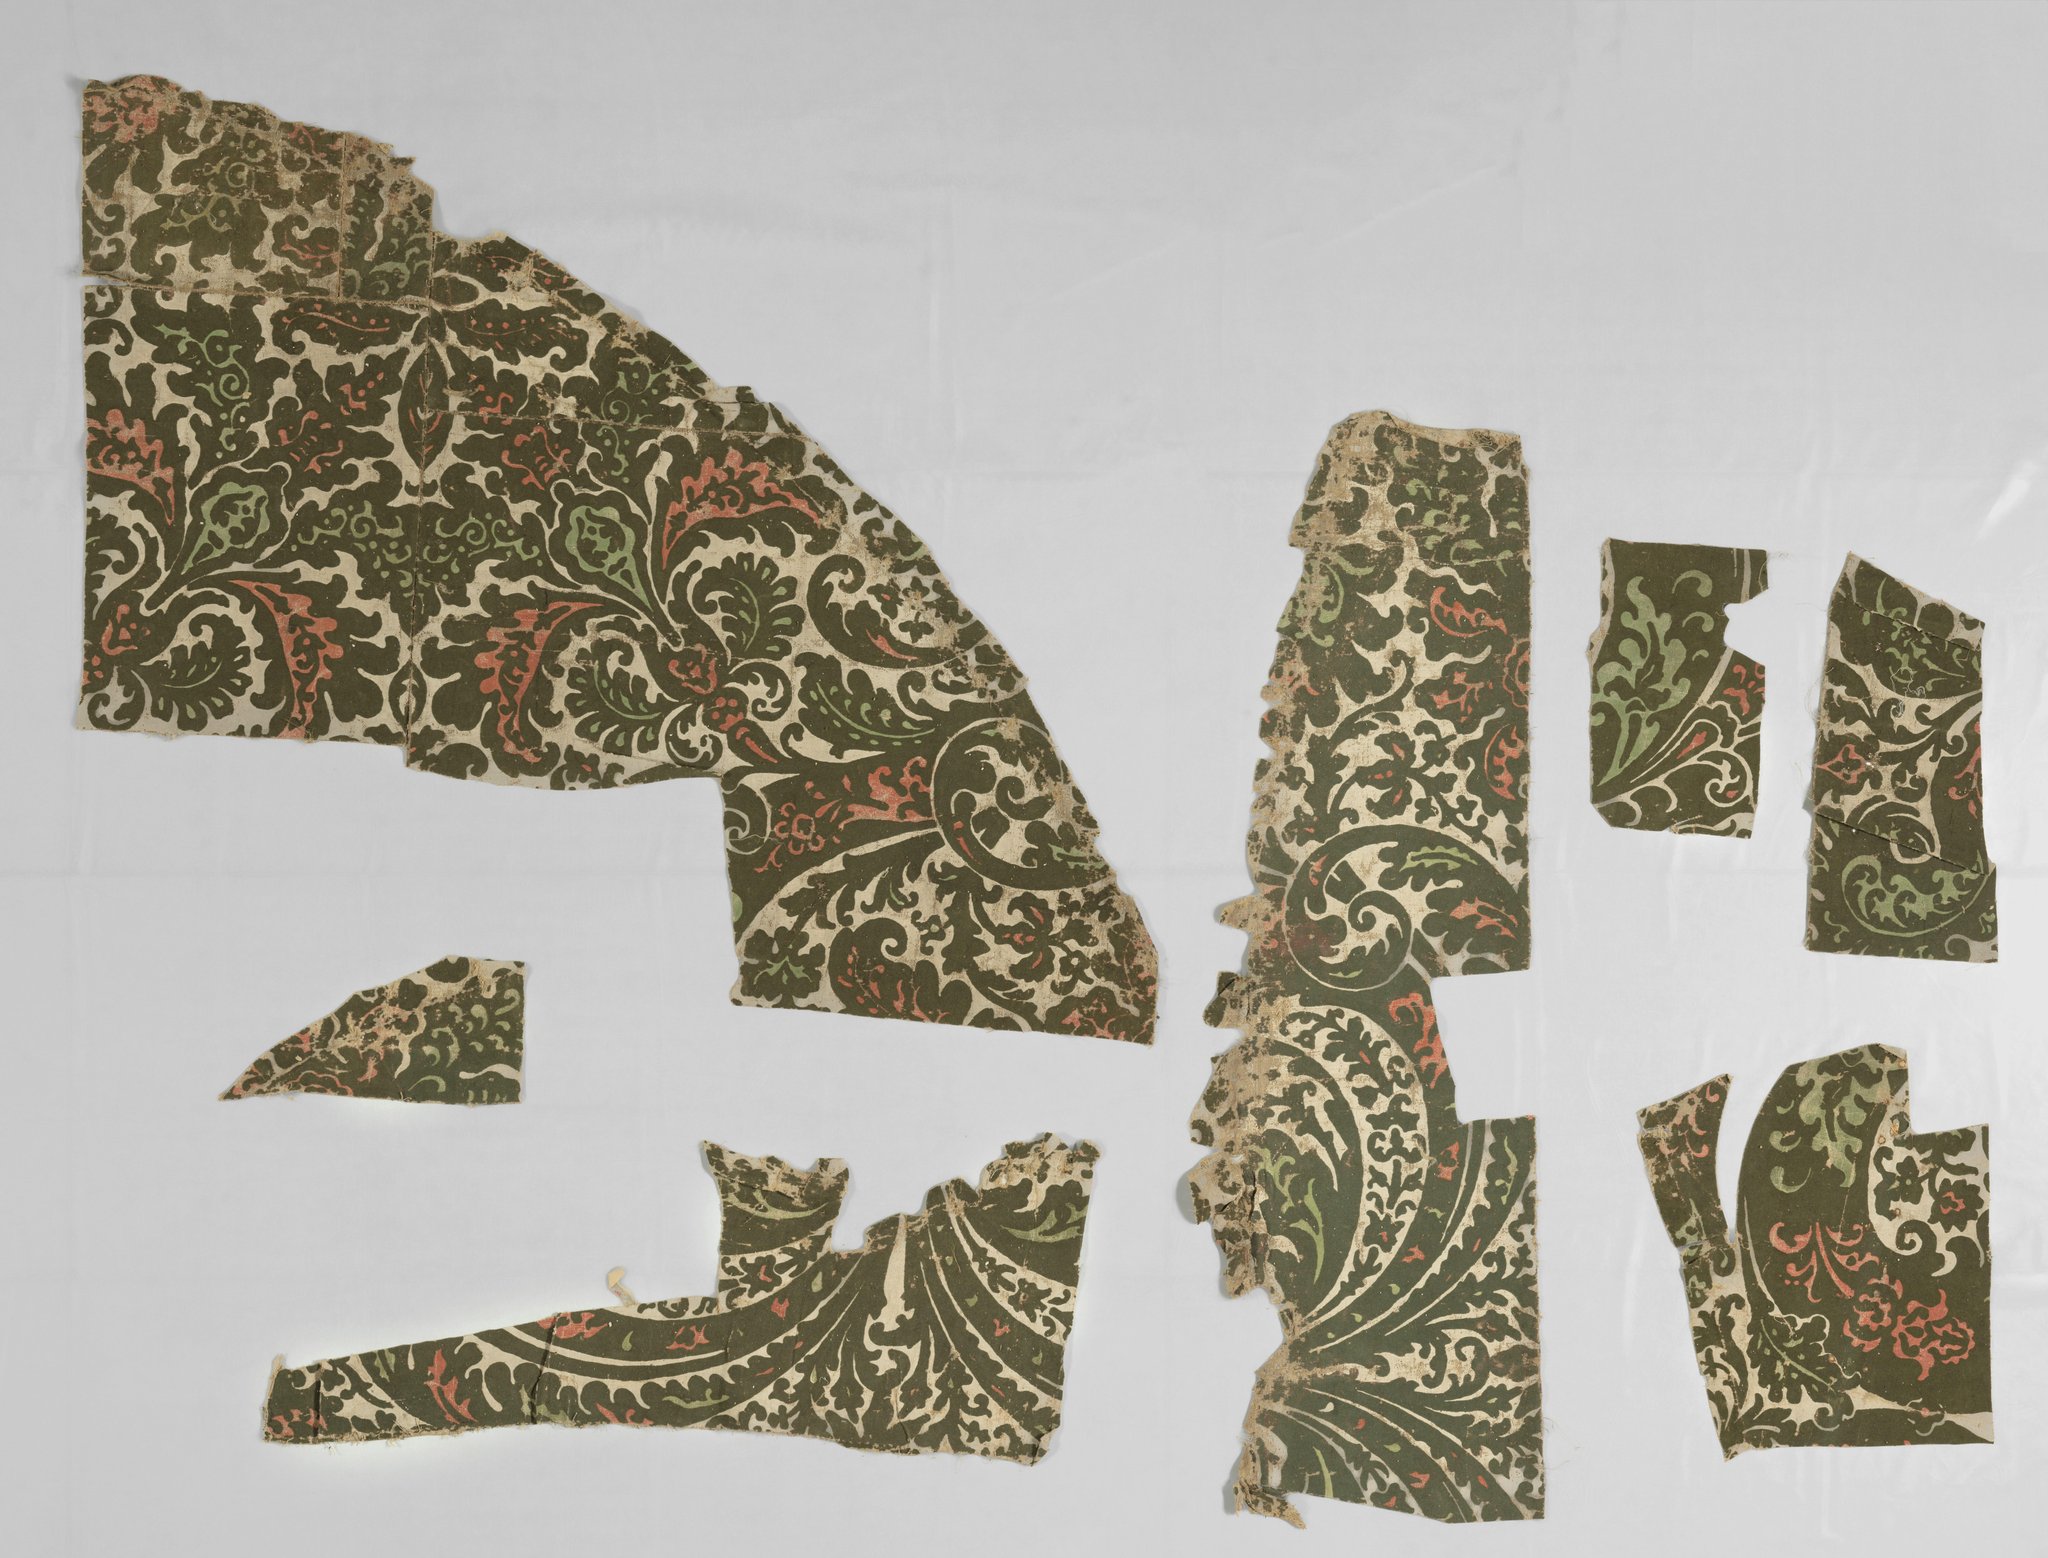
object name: interieuronderdeel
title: Fragmenten van behang van groen velouté met patroon van ranken met blad- en lofwerk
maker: Anonymous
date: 1675-1725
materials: linen, wool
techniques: velvet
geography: northern netherlands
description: Zeven fragmenten van veloutébehang dat op een gebroken wit fond een patroon van groen velouté met rode en lichtgroene vullingen vertoont. Het patroon bestaat uit grote zware ranken met blad- en lofwerk boven een lage lambris met panelen.